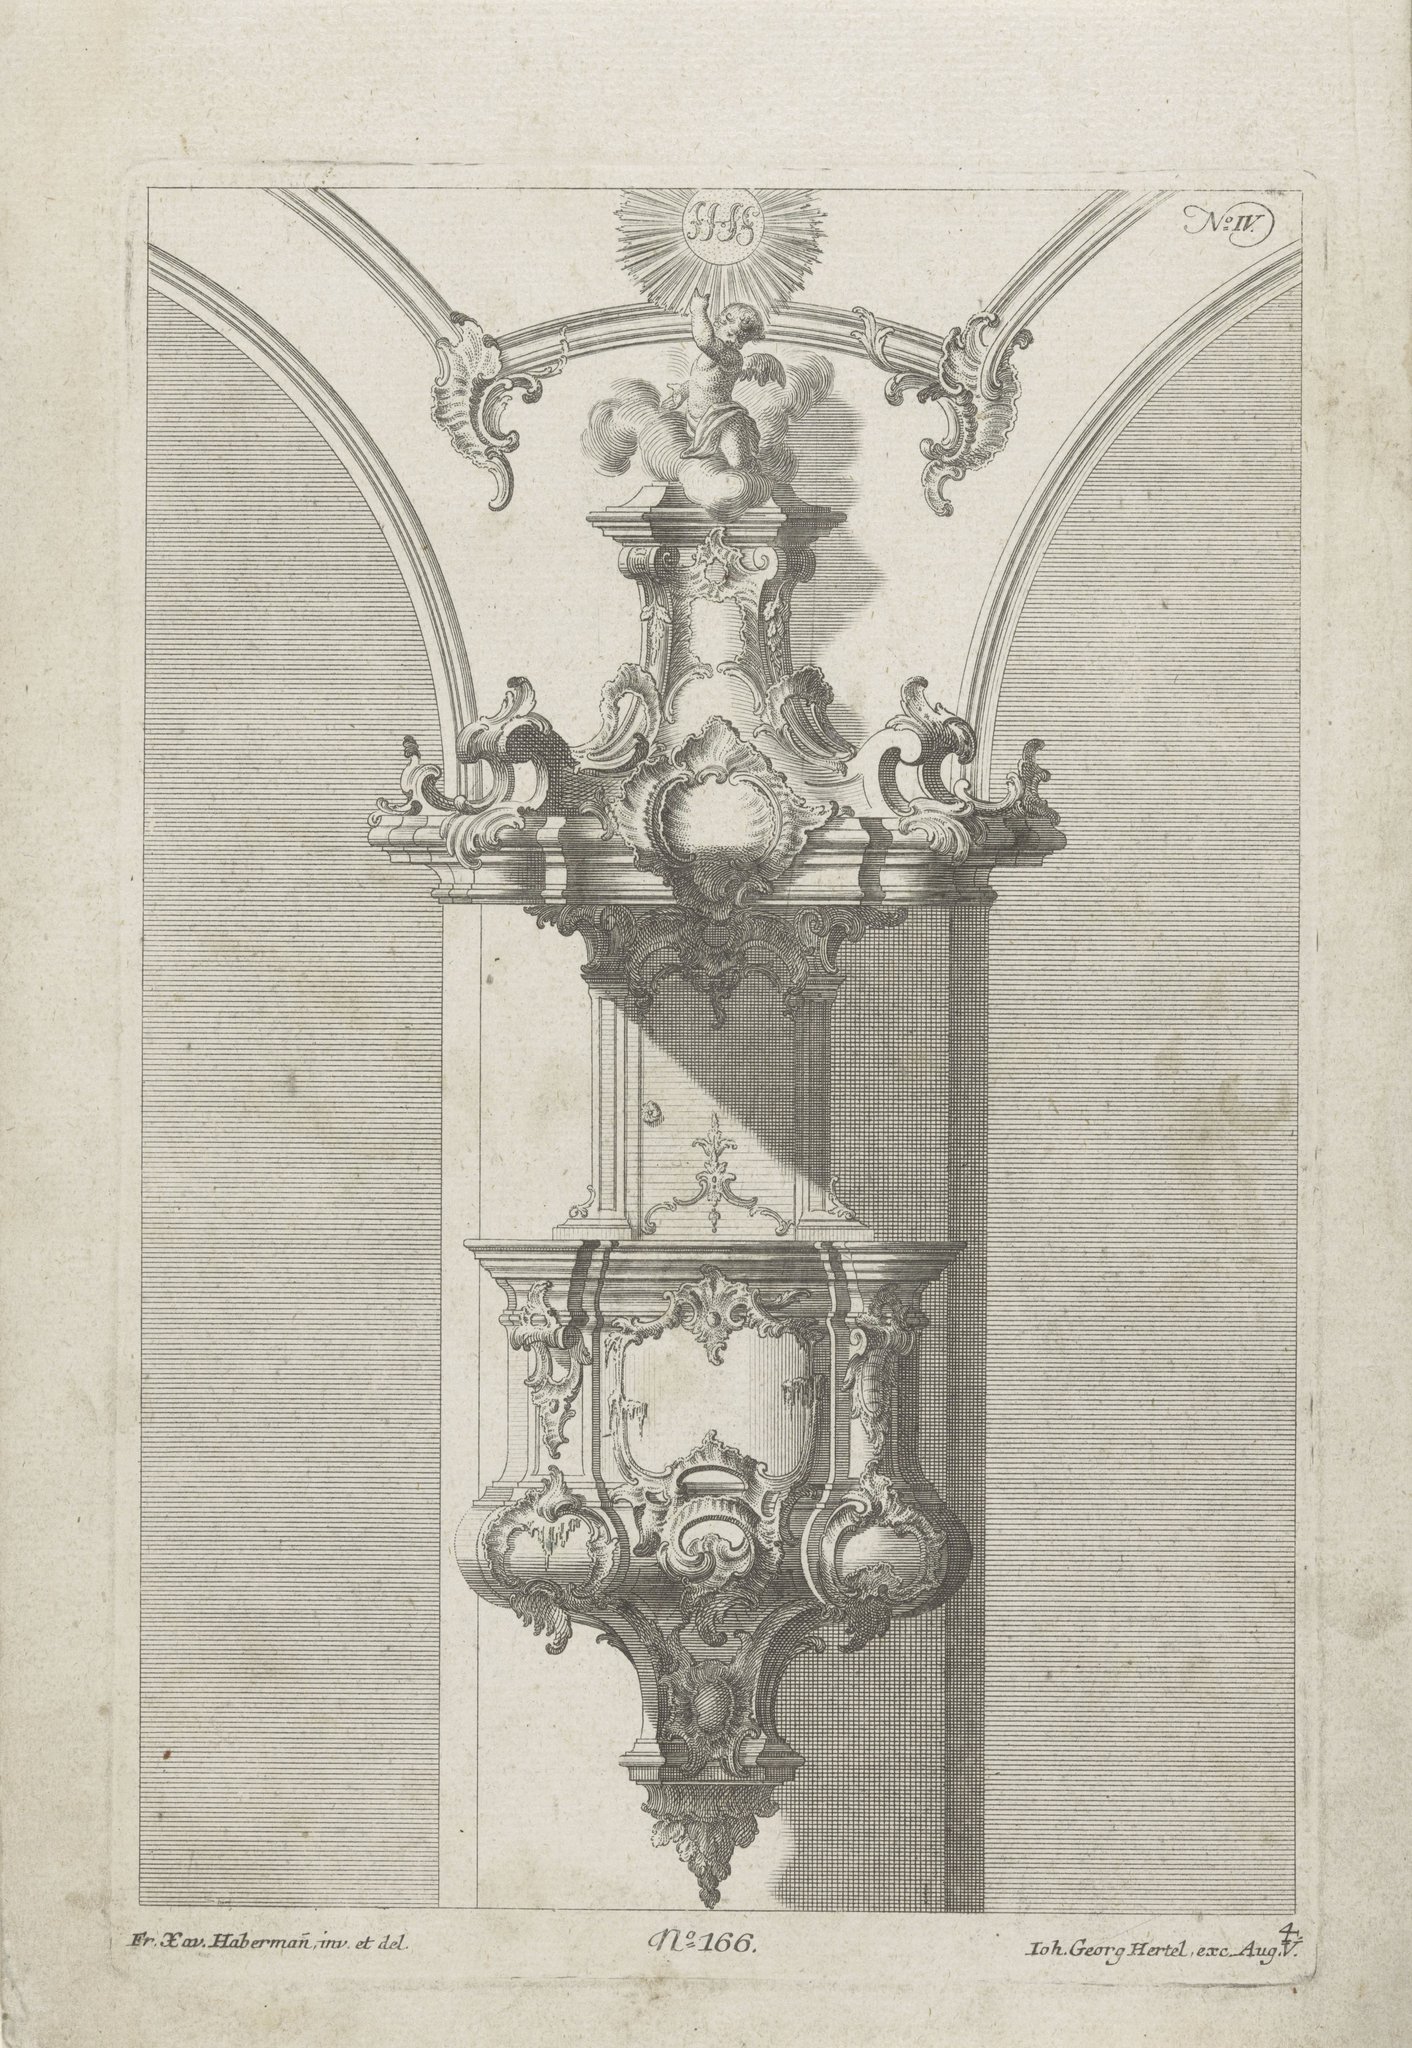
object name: print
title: Preekstoel met putto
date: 1740-1745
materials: paper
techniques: engraving, etching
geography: augsburg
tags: rocaille ornament, ihs ('iesus hominum salvator') ~ symbol of christ, pulpit, ambo, chancel, cupids: 'amores', 'amoretti', 'putti'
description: Preekstoel met rocaille ornamenten tussen twee bogen. Aan bovenzijde een gevleugelde putto die wijst op de letters IHS in stralenkrans. Uitgeversnummer 166.